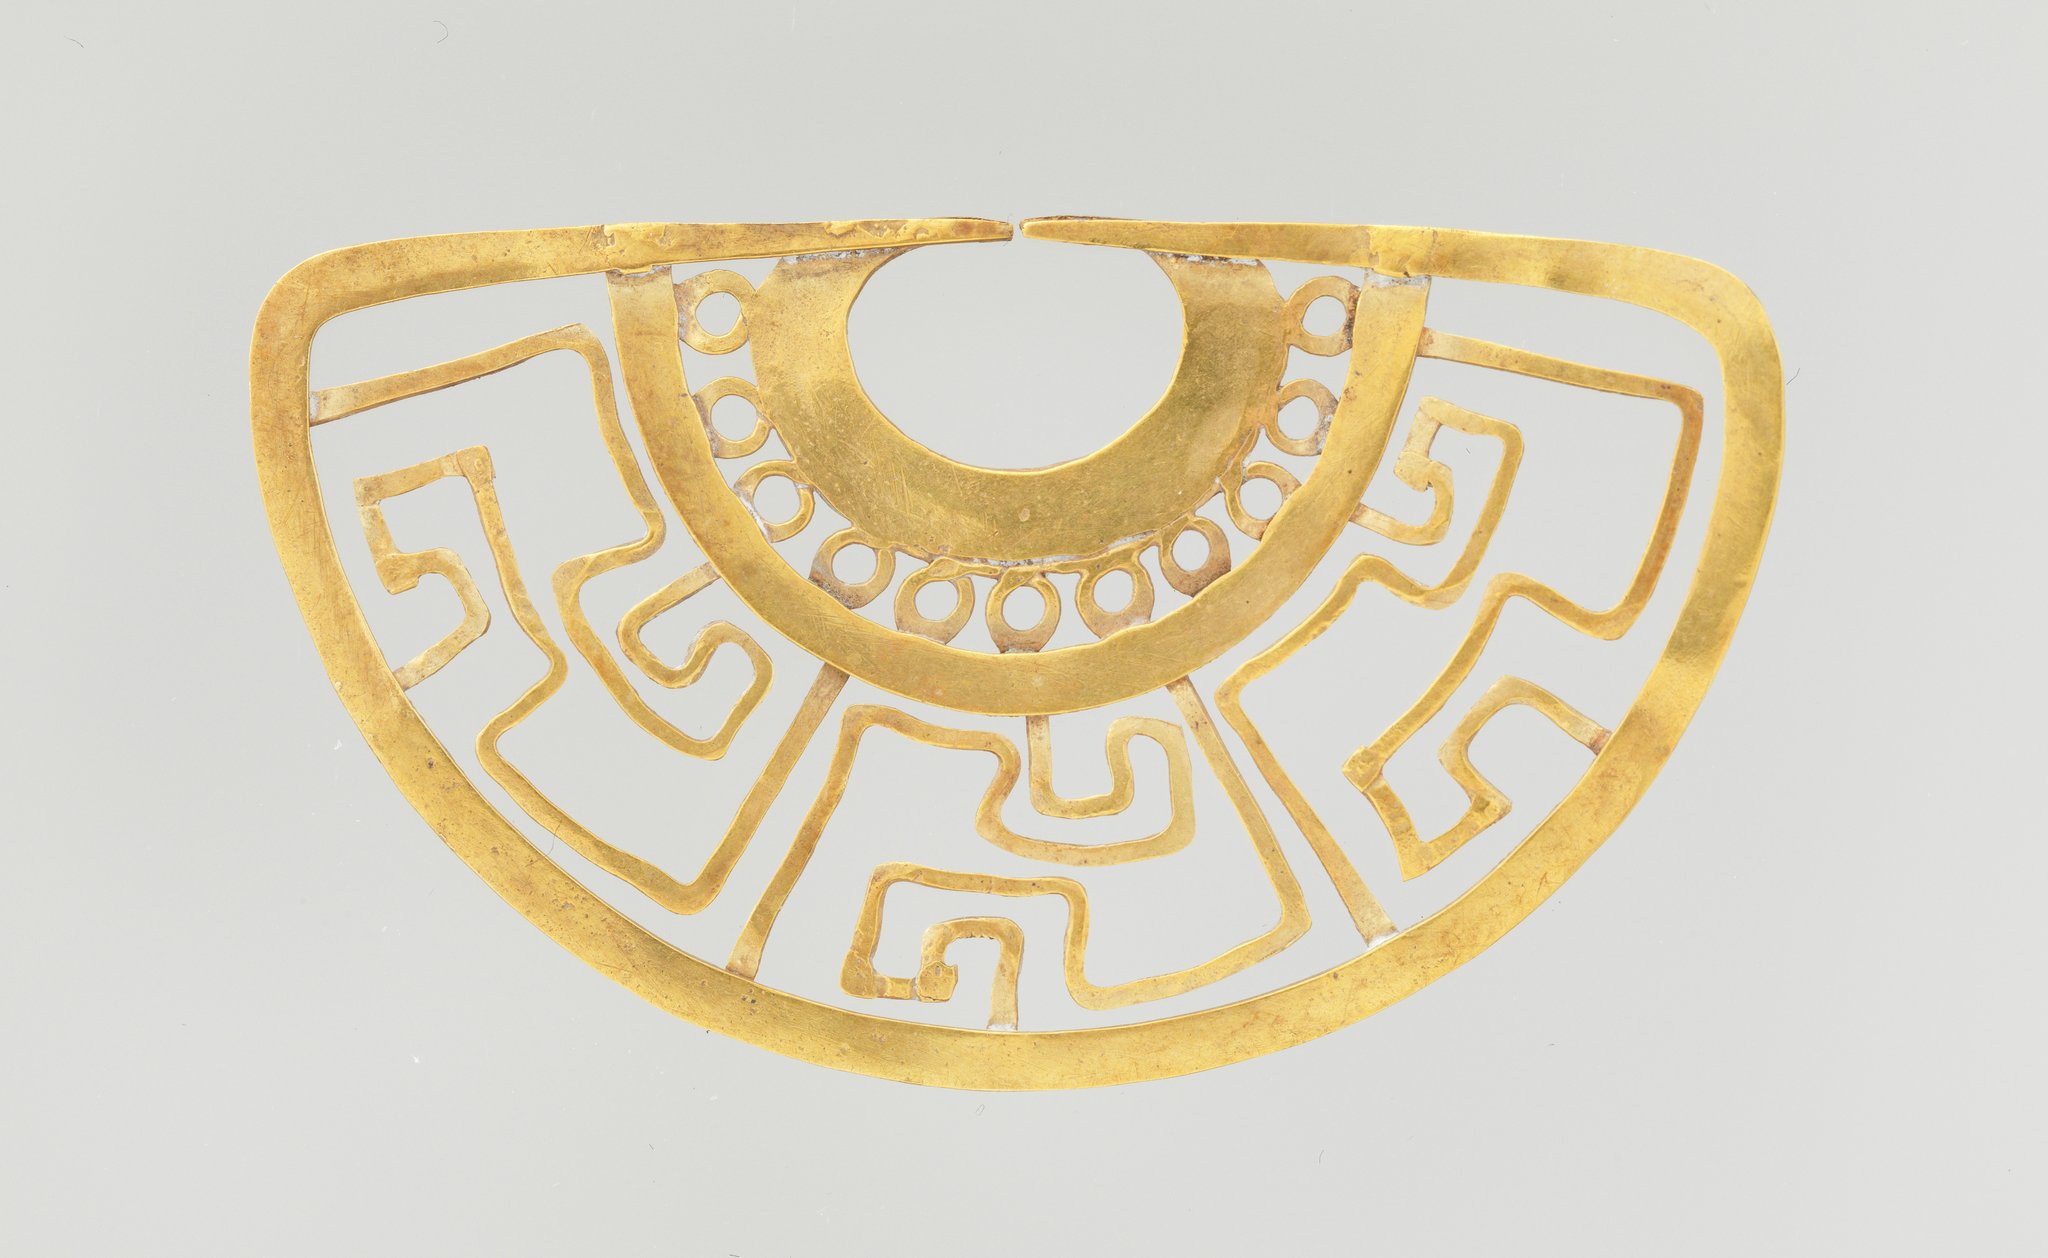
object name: nose ornament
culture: salinar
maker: salinar artist(s)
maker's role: artist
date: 500-100 BCE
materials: gold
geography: peru